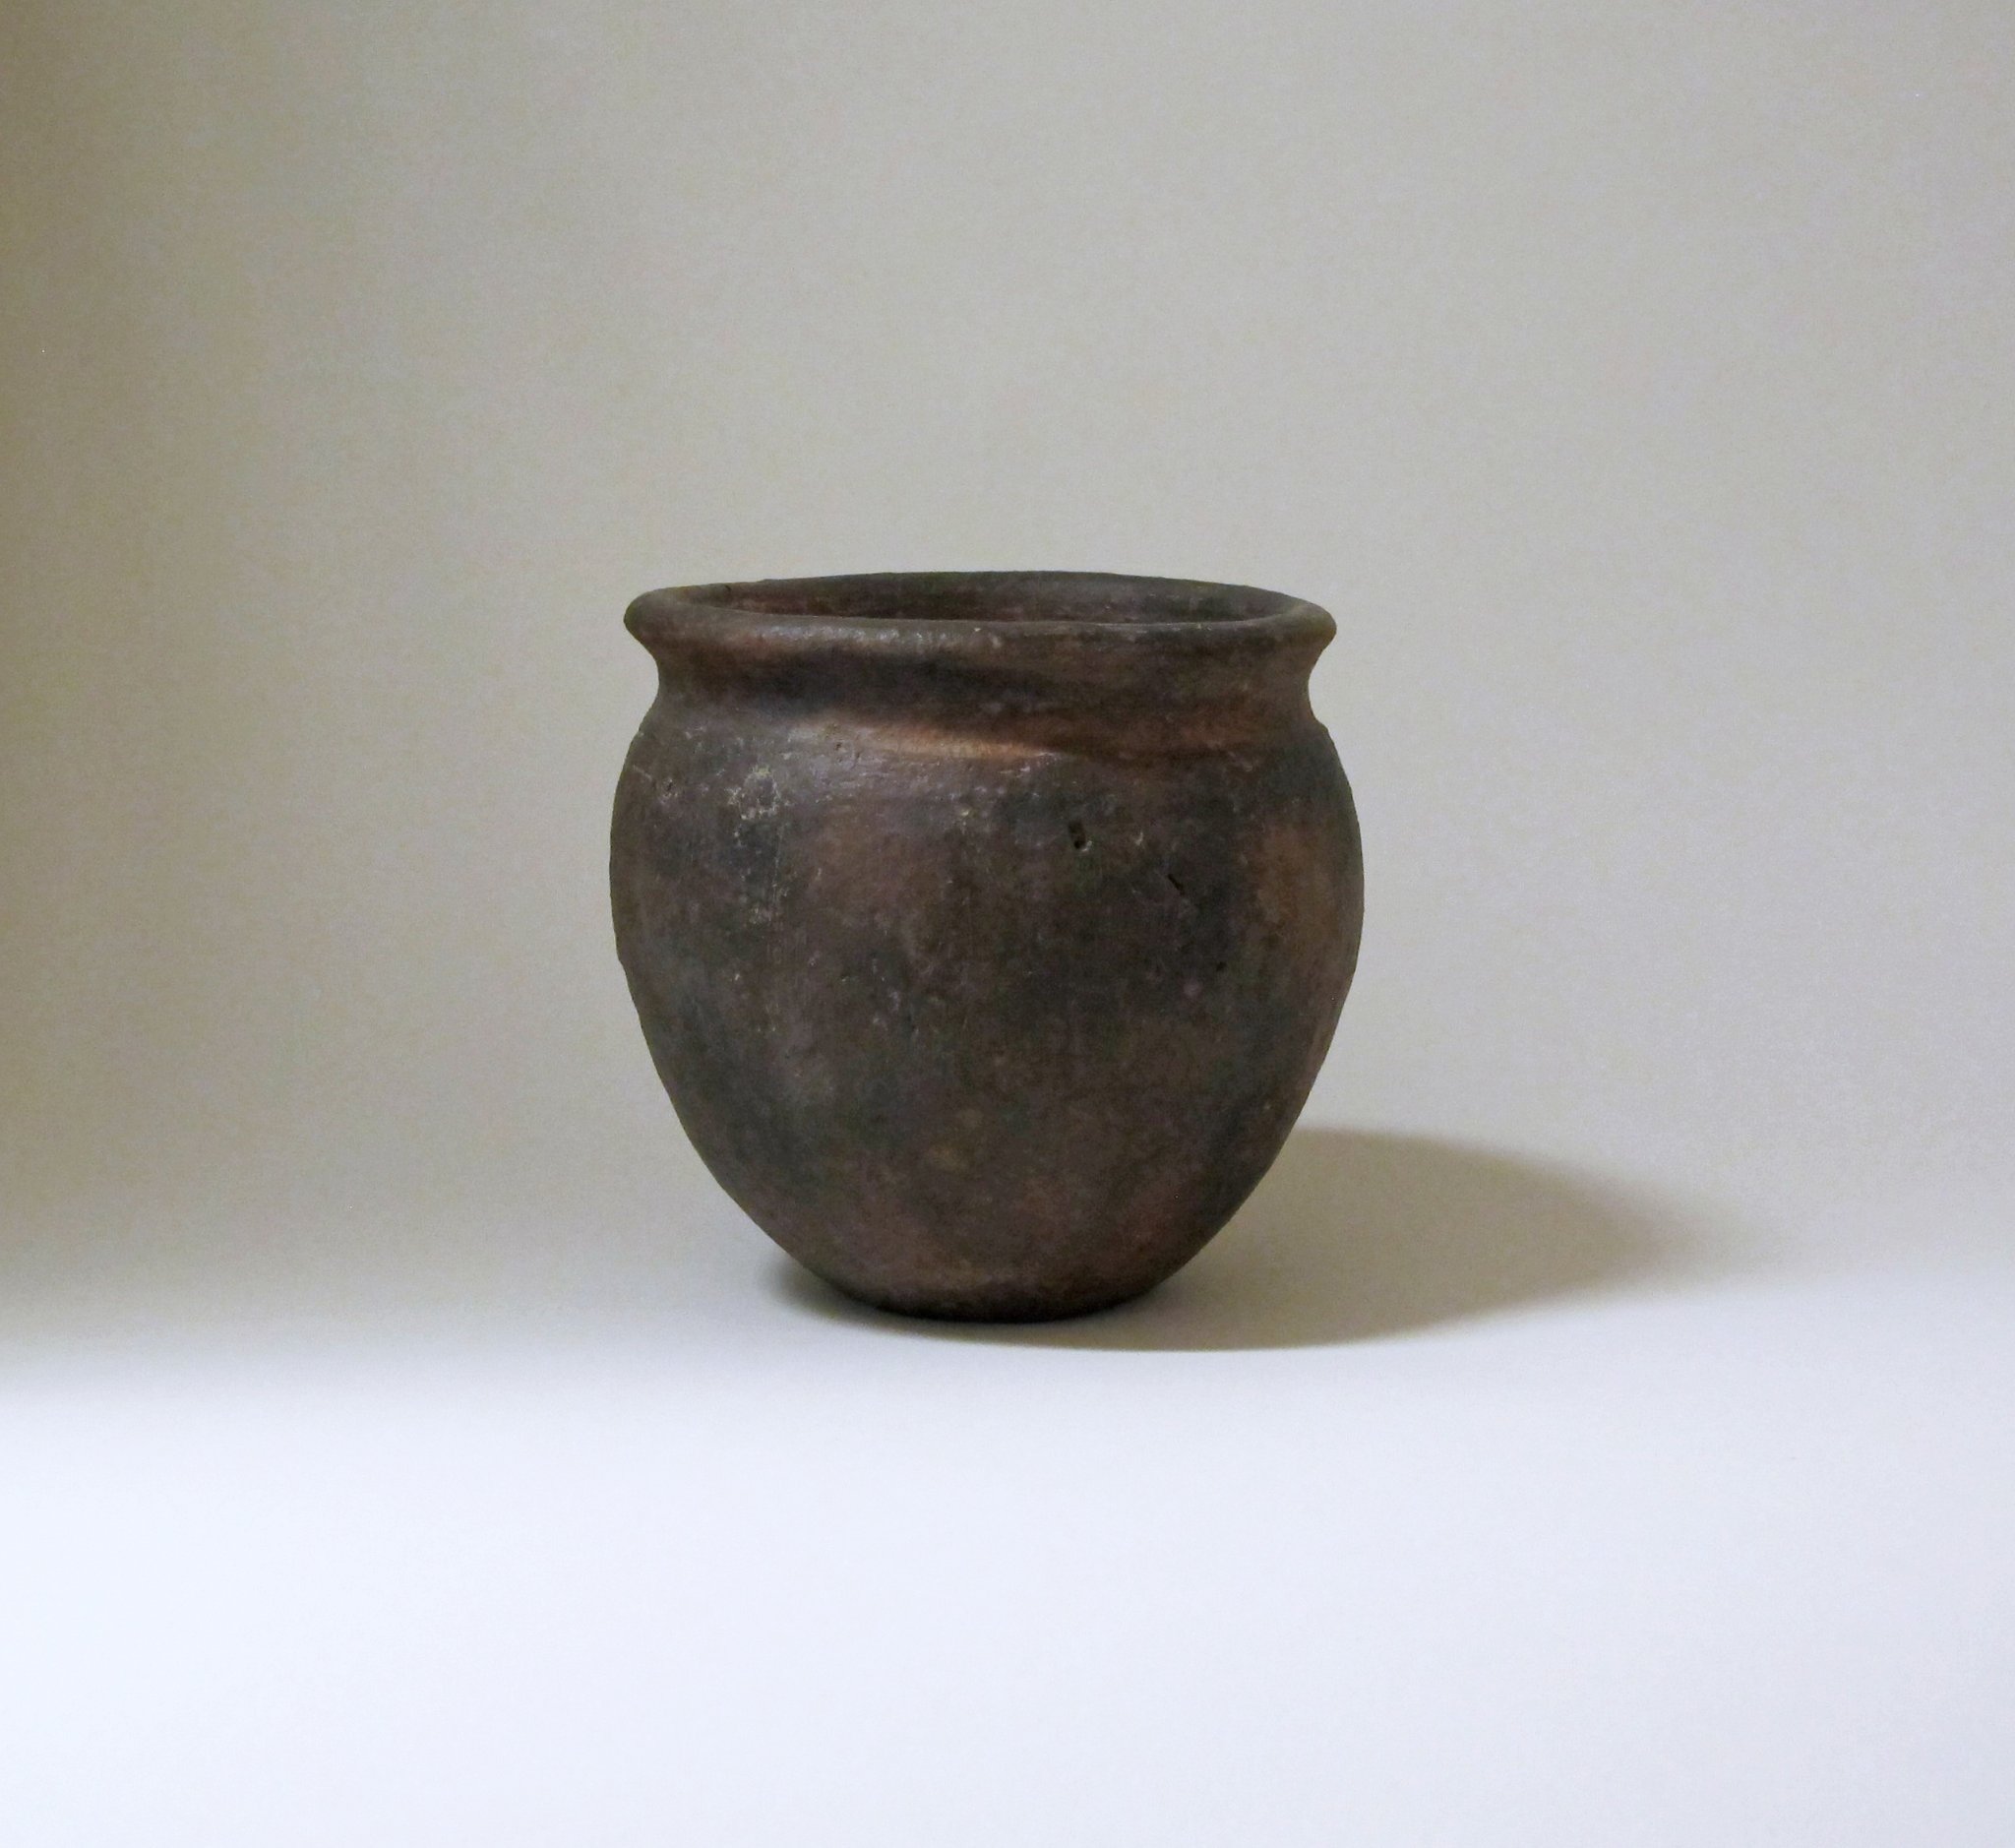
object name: bowl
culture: etruscan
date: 650-500 BCE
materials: terracotta